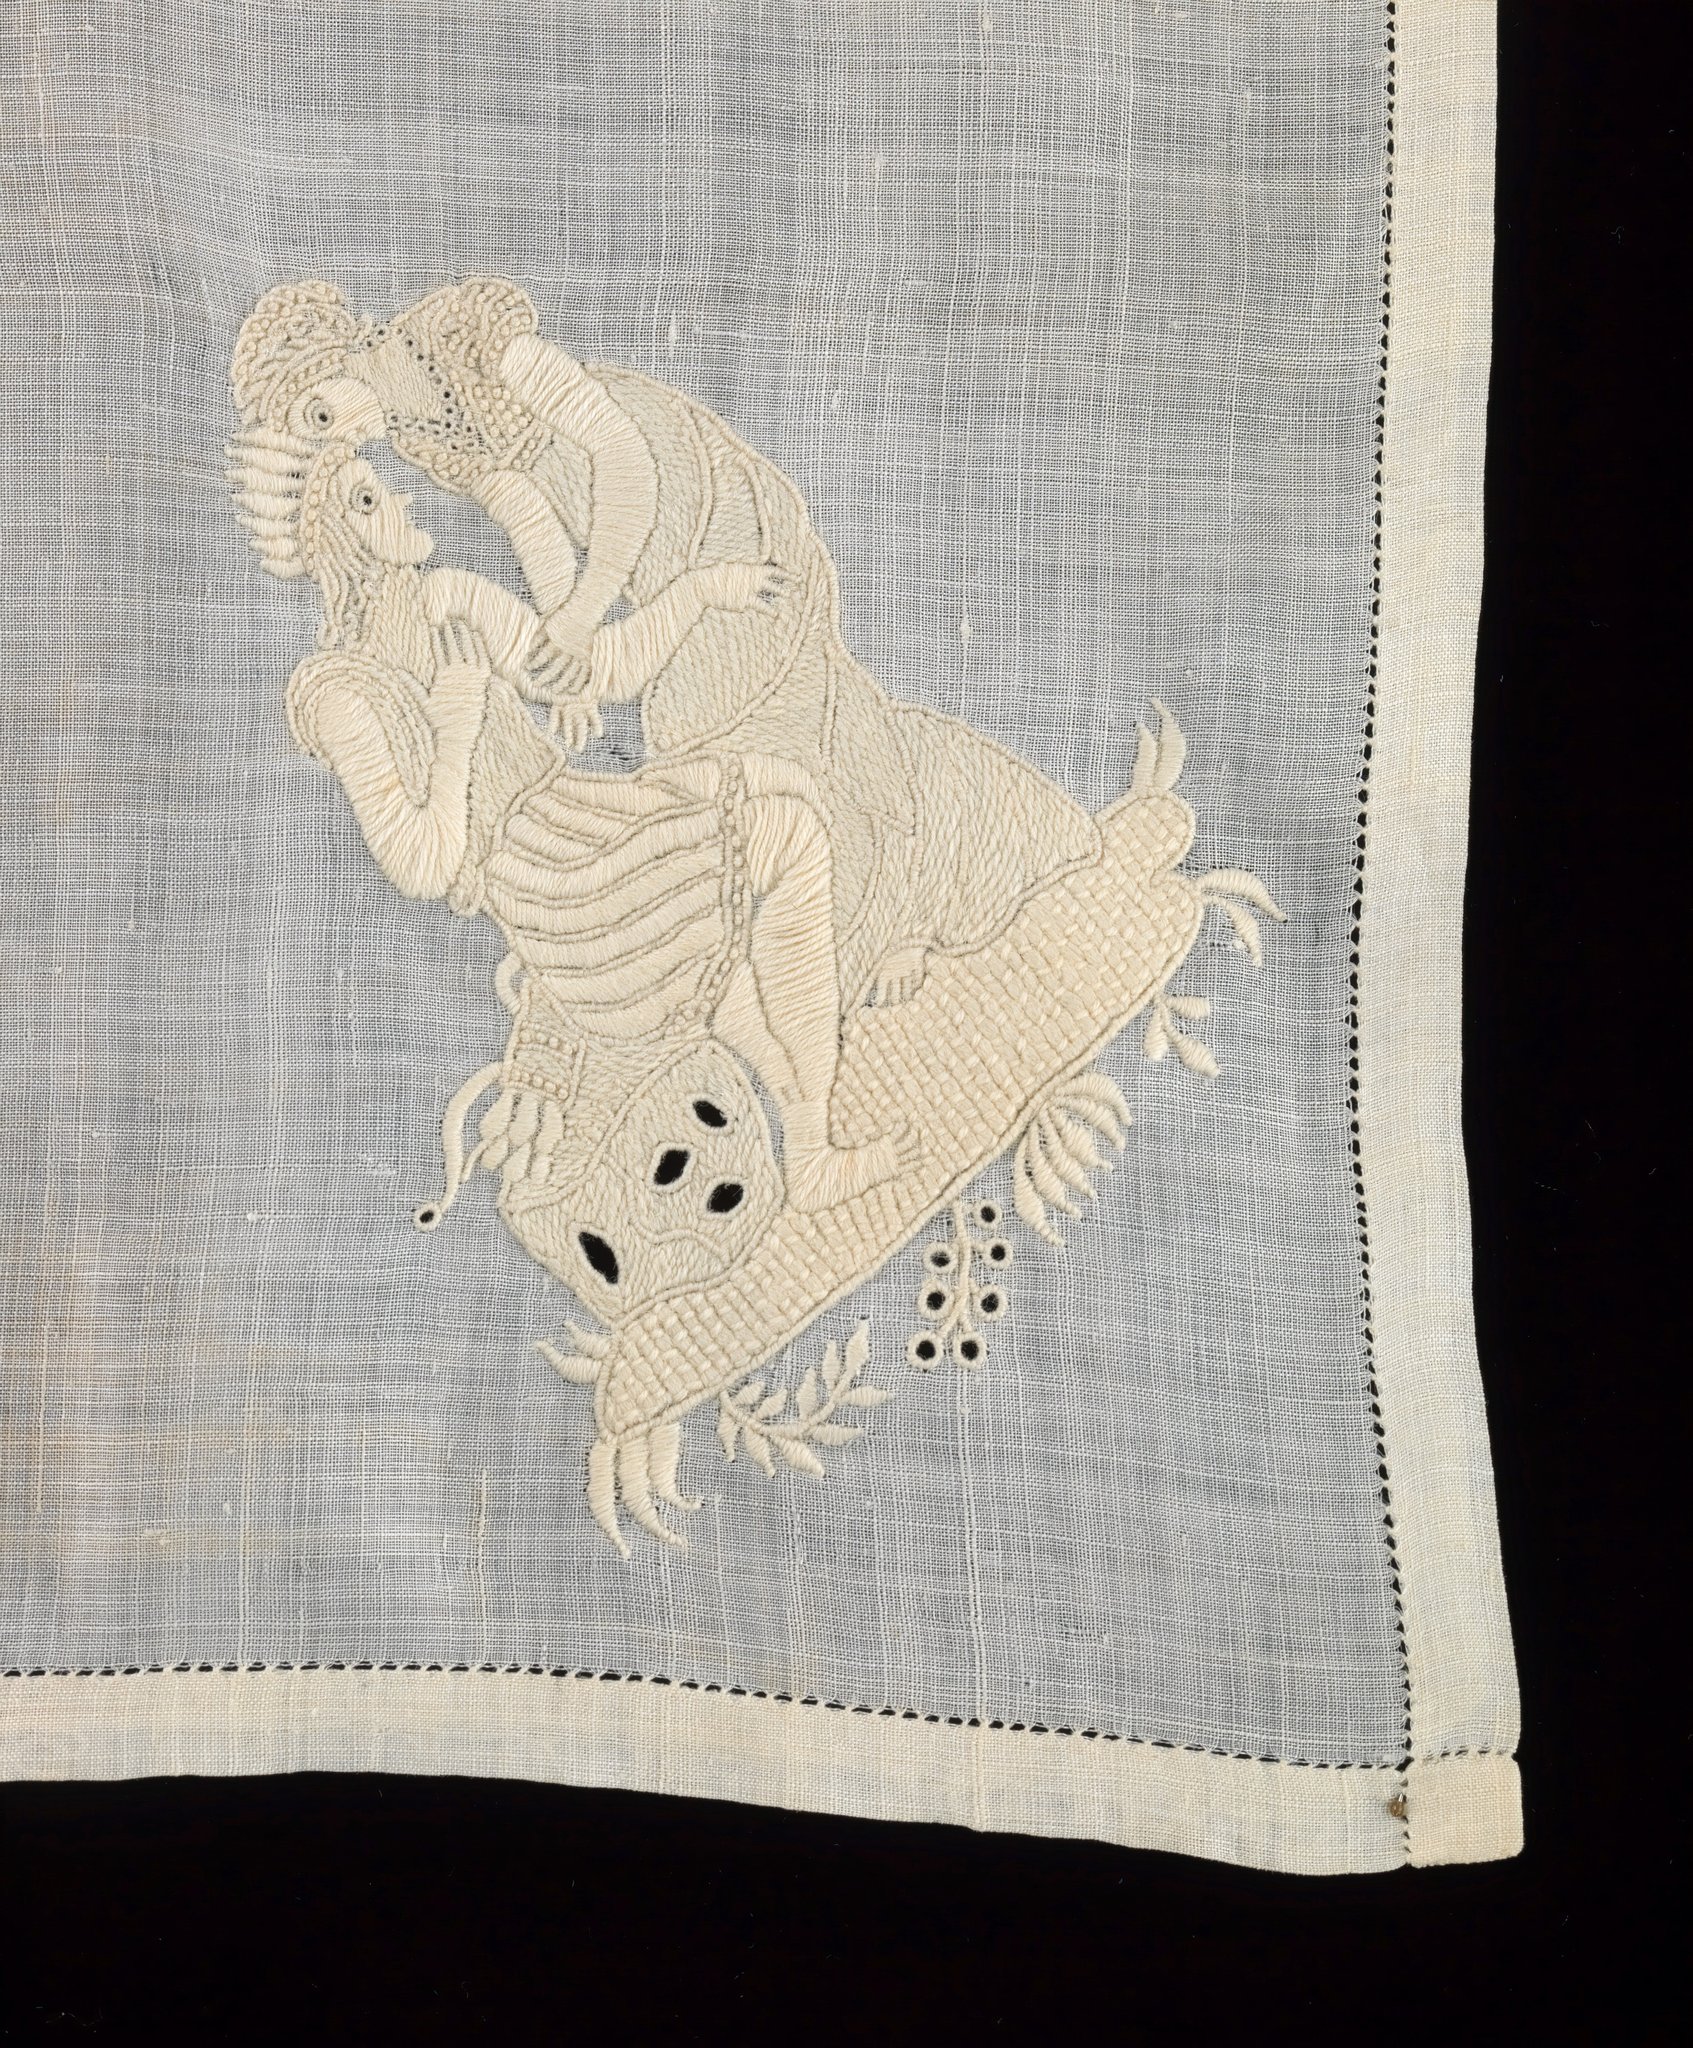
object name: handkerchief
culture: french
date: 1851-1900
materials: linen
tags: cupid,narcissus